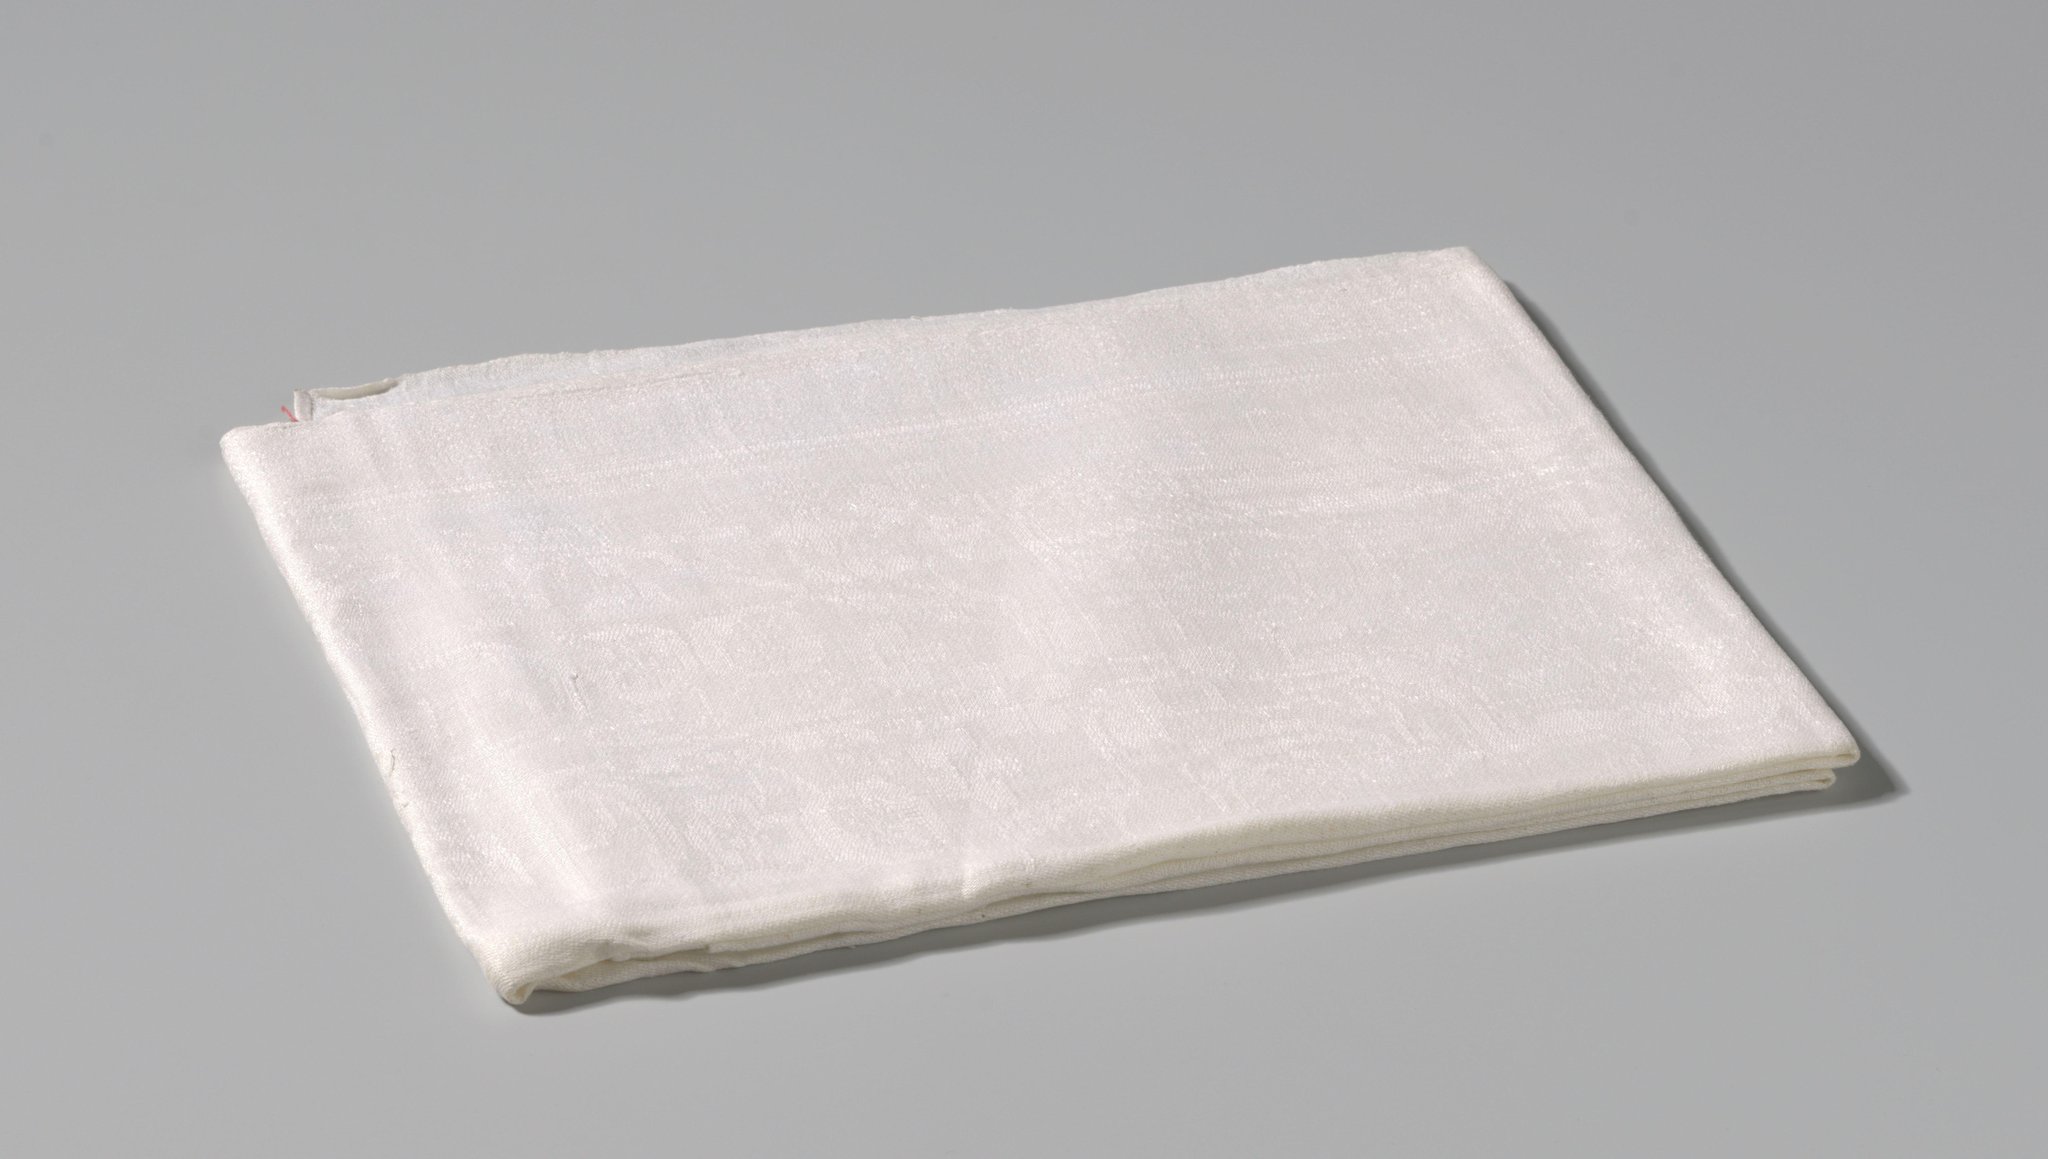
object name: napkin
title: Servet van linnendamast met een bloempatroon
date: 1725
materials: linen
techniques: damask, weave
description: Servet van linnendamast met bloemen en een regence-ornament. Het servet hoort bij negen servetten (BK-1974-87-A t/m BK-1974-87-J) en een tafellaken (BK-1974-86).